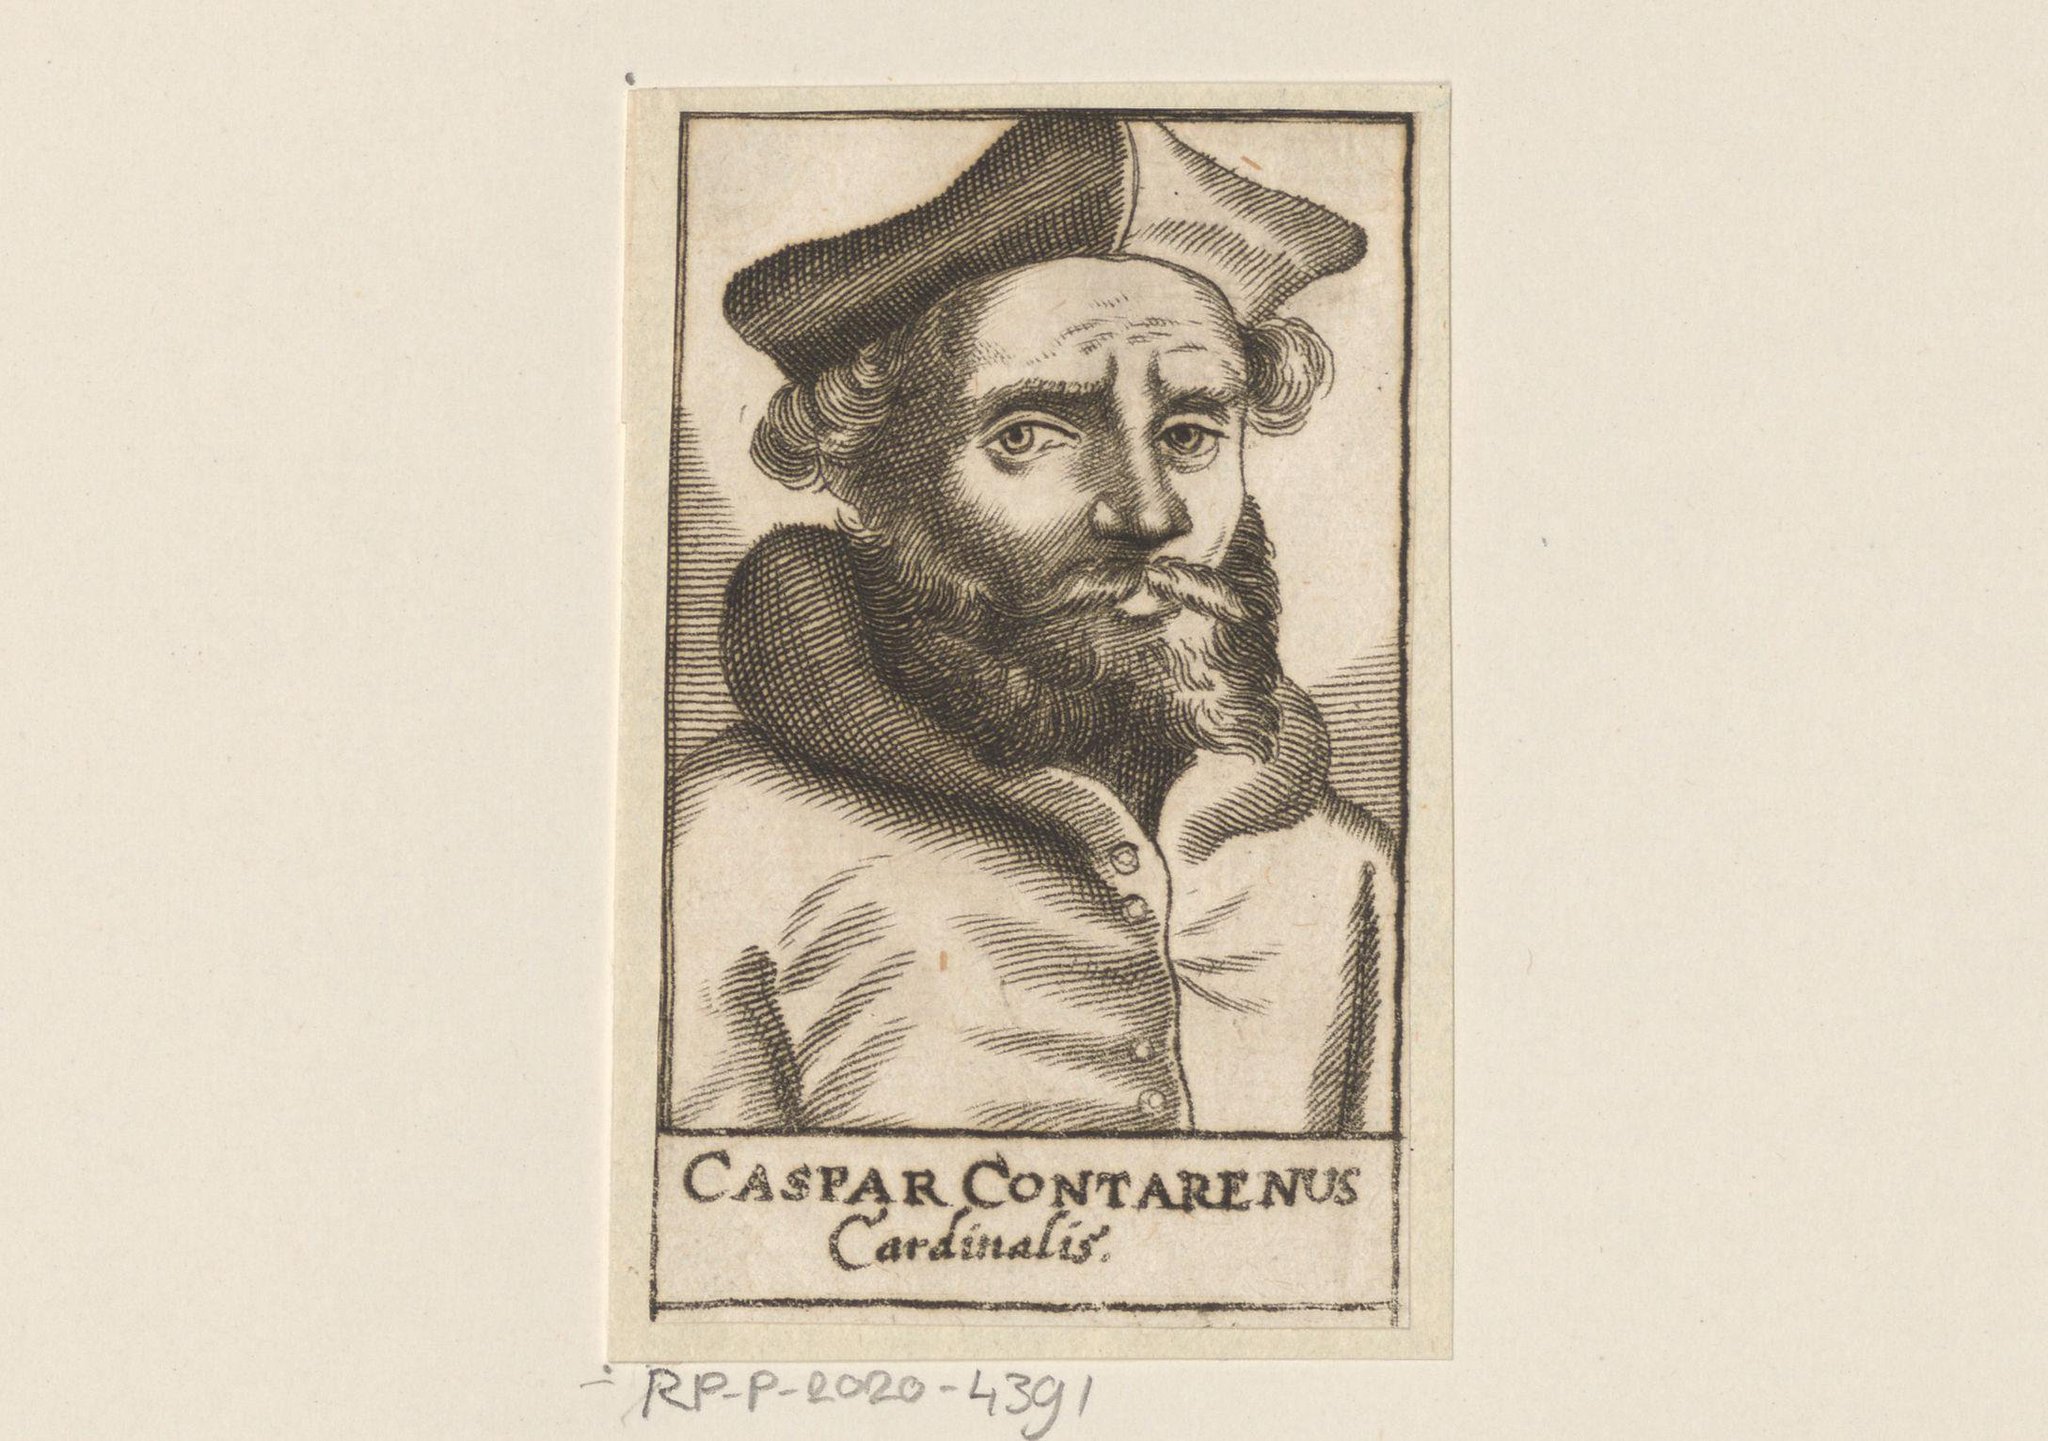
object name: print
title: Portret van Gaspar Contarini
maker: Anonymous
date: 1688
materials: paper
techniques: engraving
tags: venice, historical persons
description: Prent maakt deel uit van een grotere prent die later is verknipt. Prent waarschijnlijk uit: Freher, Paul. Theatrum virorum eruditione clarorum. Neurenberg: Johann Hoffmann, 1688.